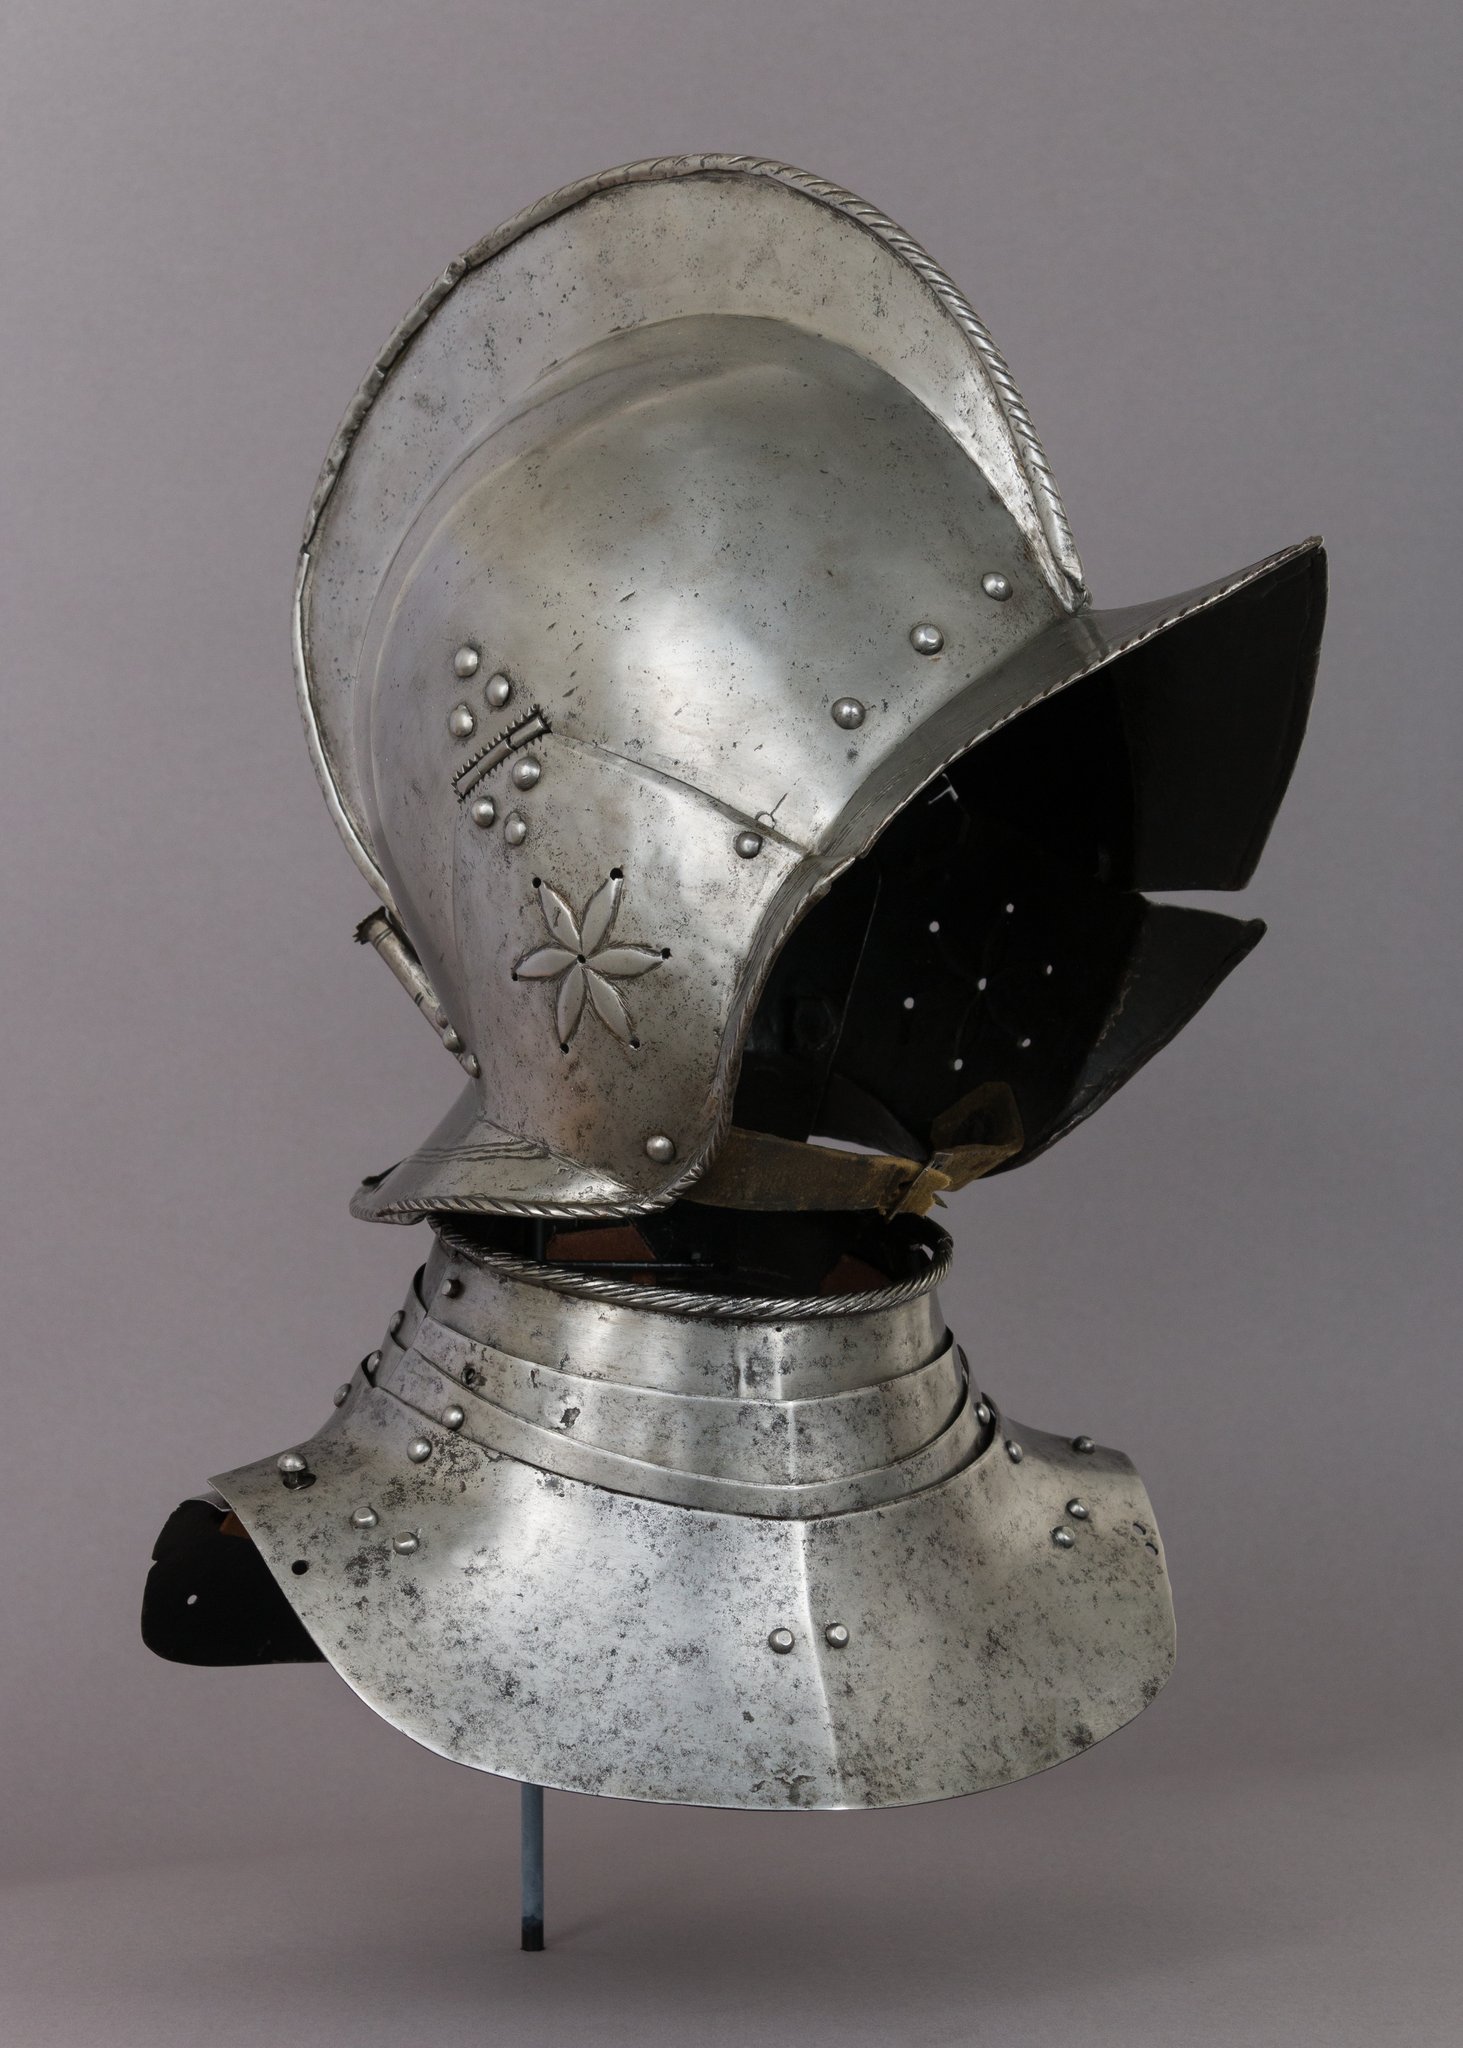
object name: helmet and gorget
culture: german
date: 1525-1575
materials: copper alloy, leather, steel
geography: germany